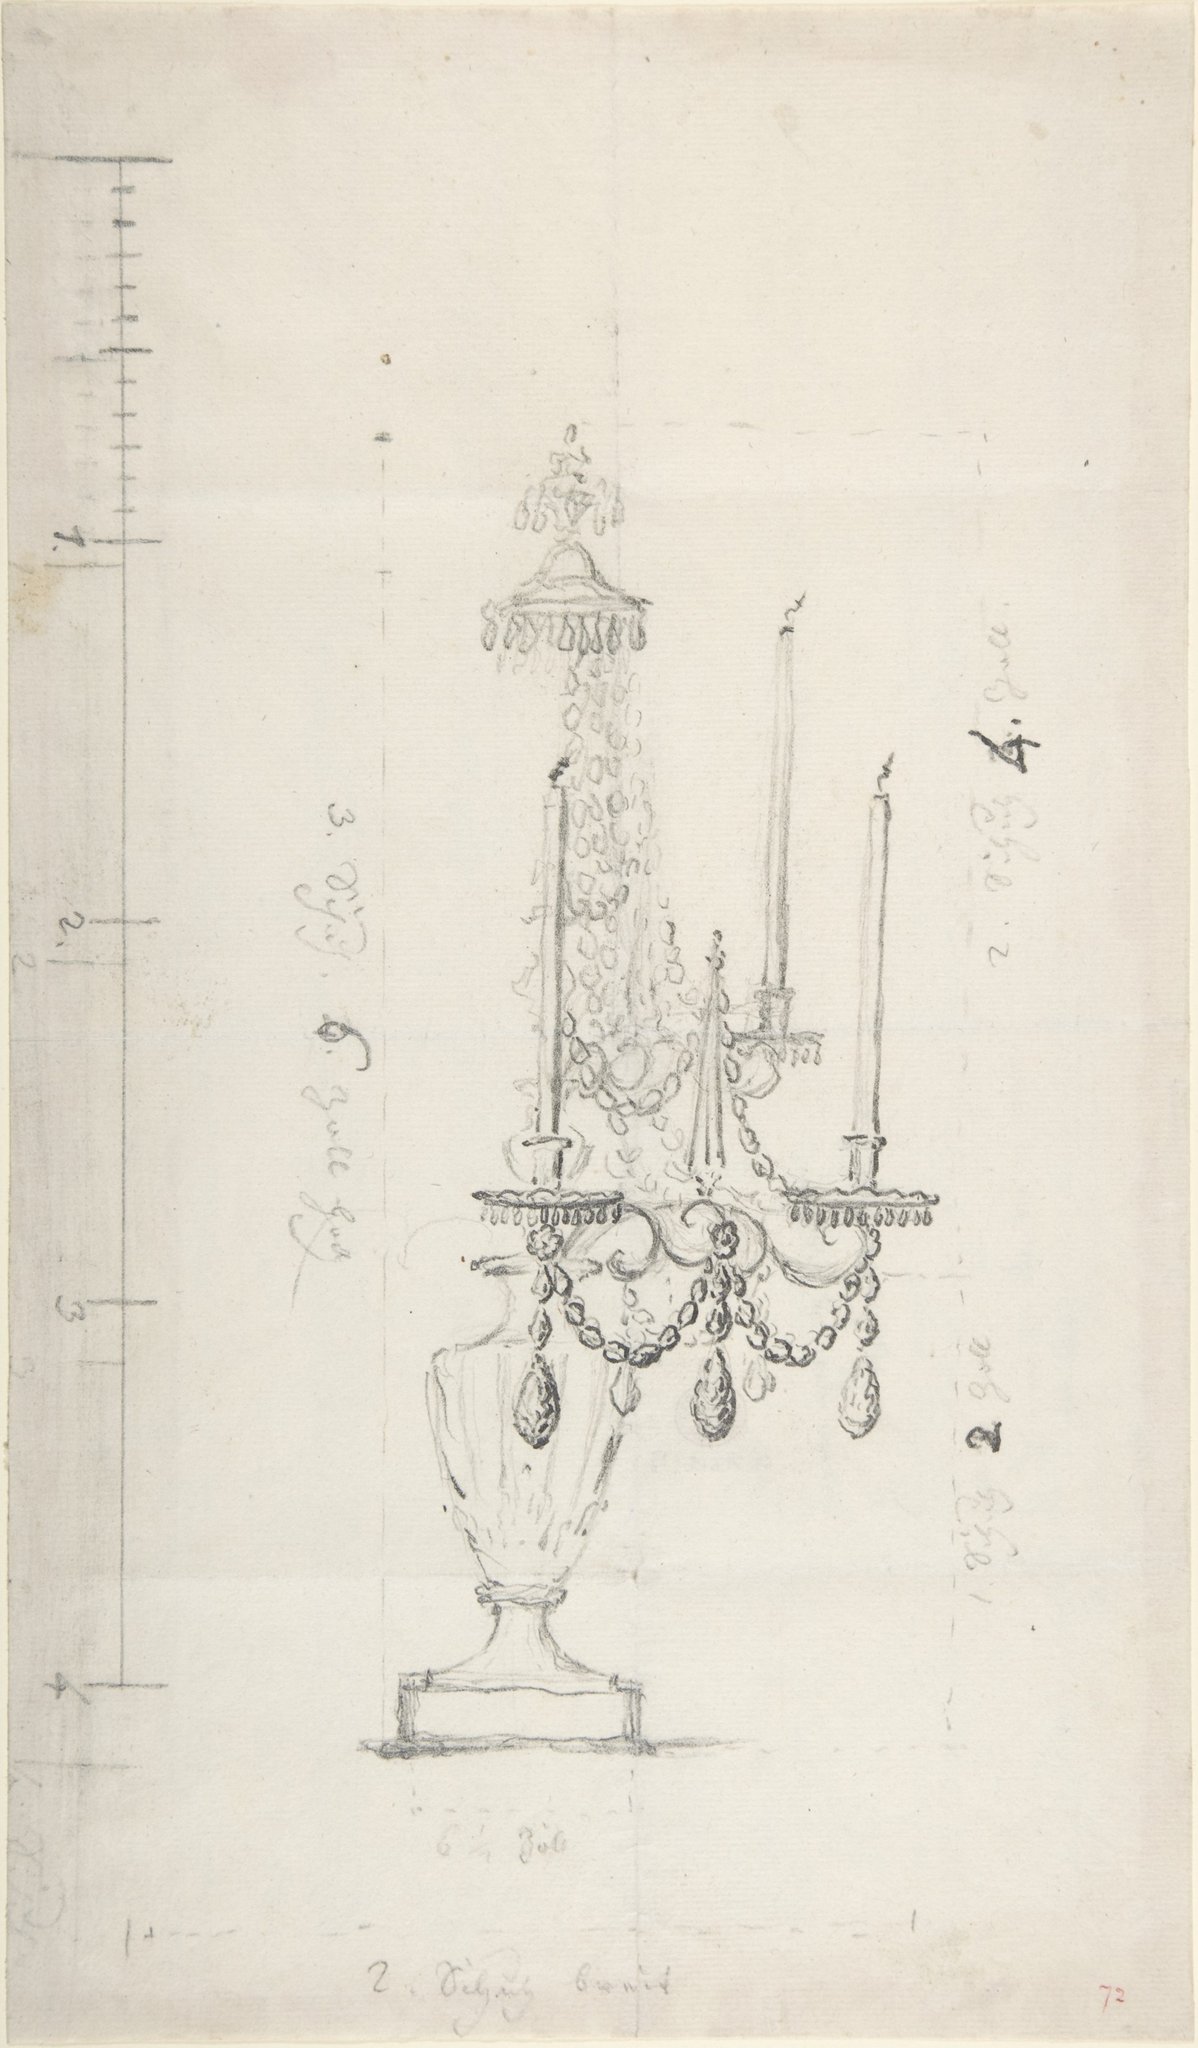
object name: drawing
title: Designs for a Chandelier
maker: anonymous, french, 18th century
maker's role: artist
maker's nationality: french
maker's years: 1700-1800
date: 1770-1790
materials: graphite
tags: chandelier